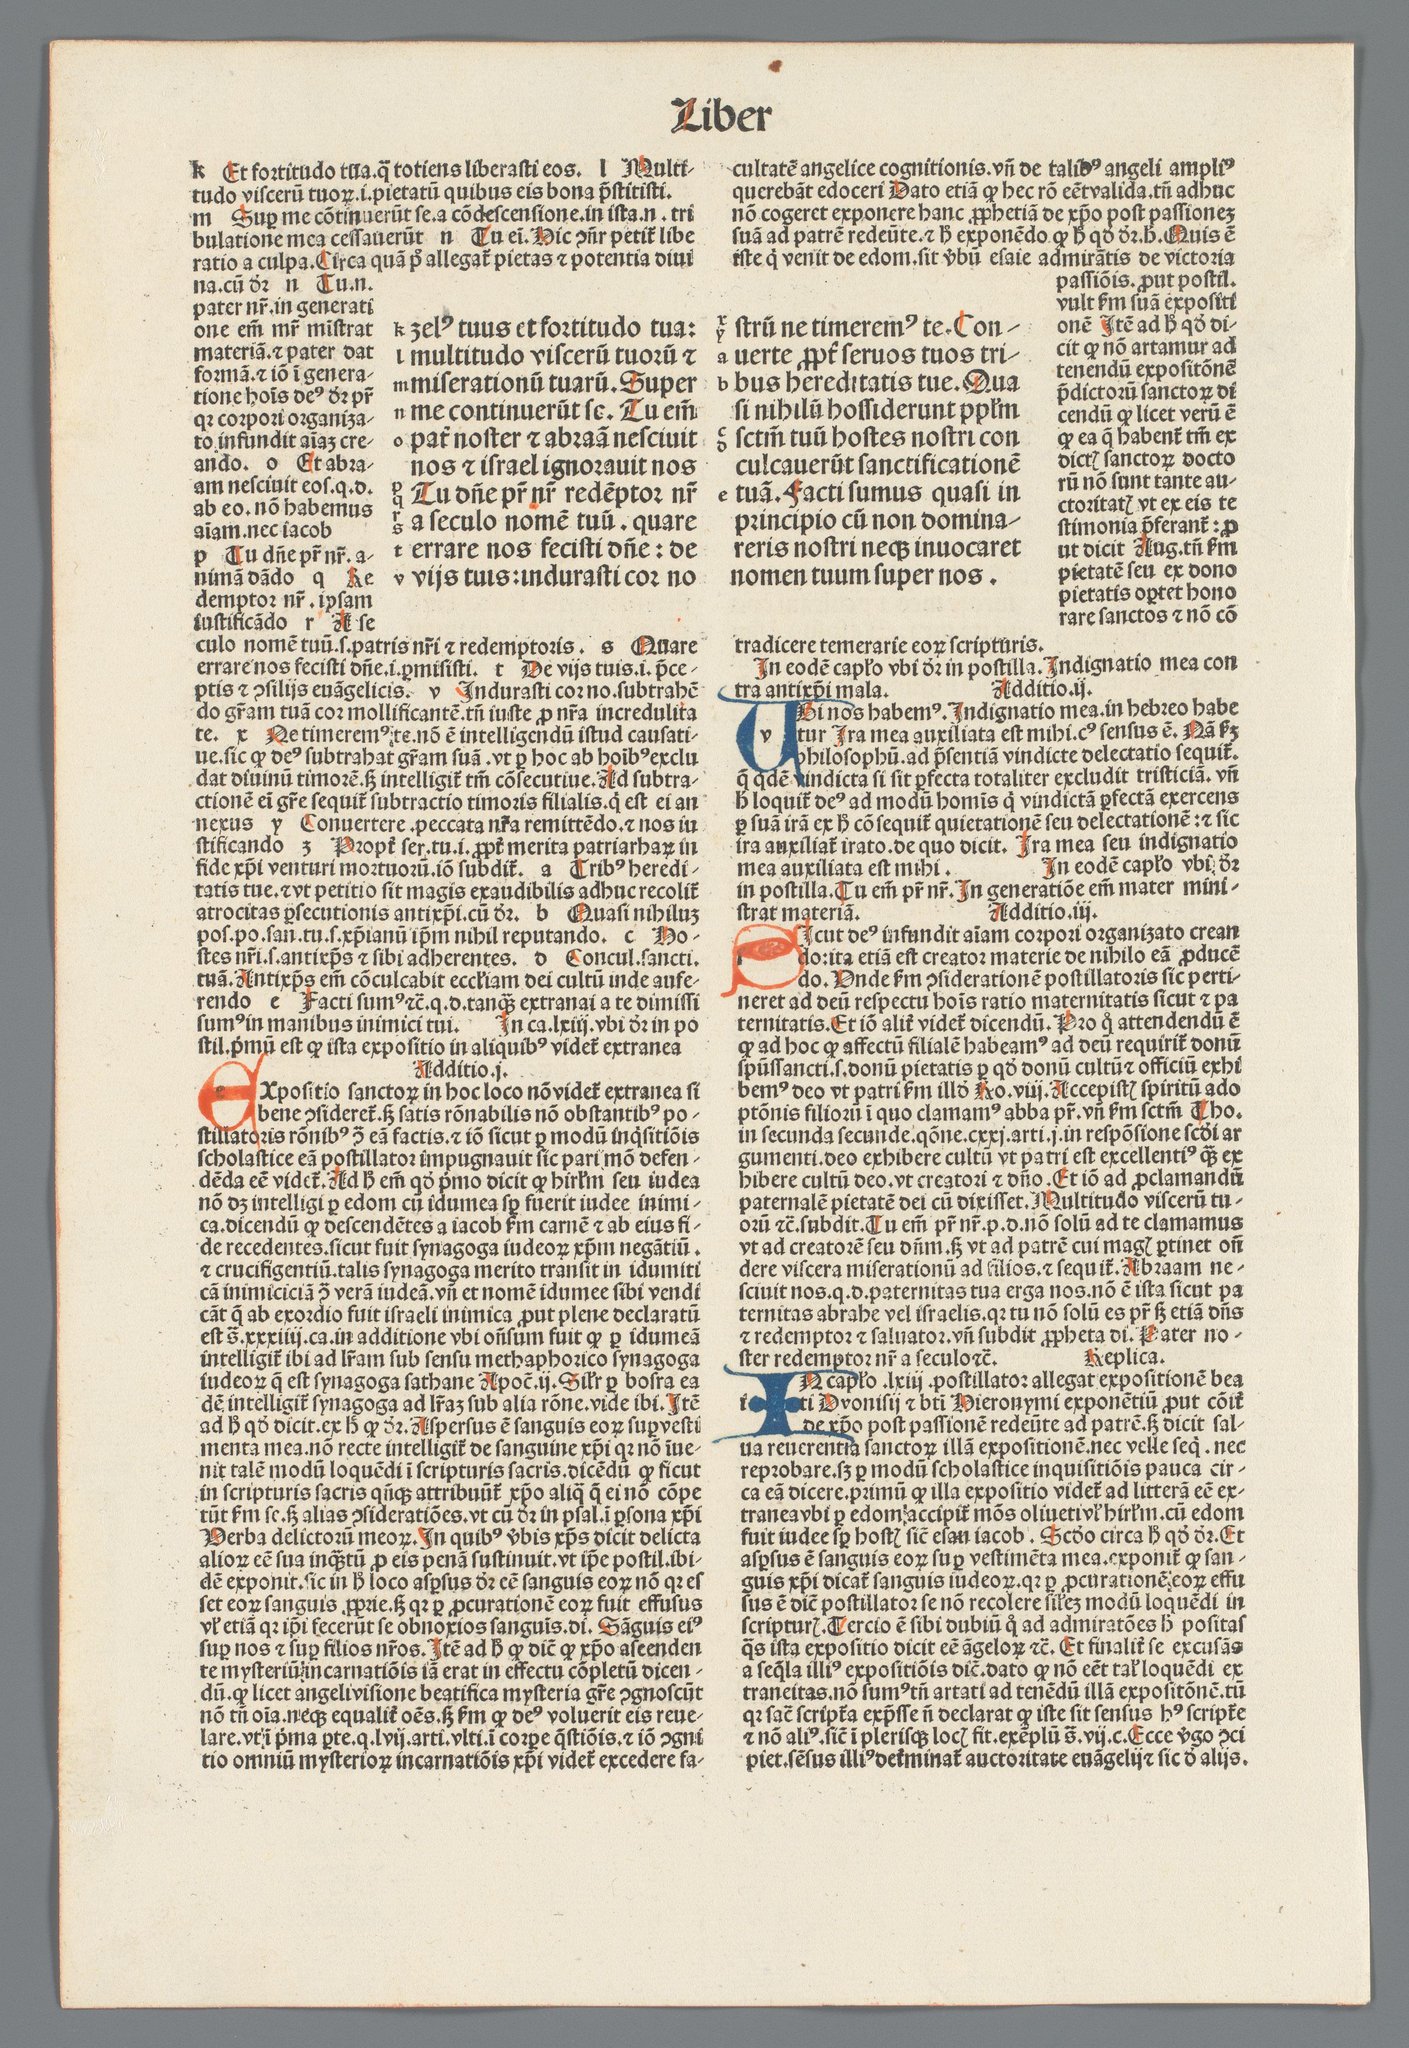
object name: text sheet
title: Bladzijde uit Biblia Latina cum Postillis Nicolai de Lyra, 1493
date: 1493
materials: paper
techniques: hand coloring, letterpress printing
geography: nuremberg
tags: the bible as a book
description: Bladzijde uit: Lyra, Nicolaas van. Biblia Latina cum Postillis Nicolai de Lyra. Neurenberg: Anton Koberger, 1493, dl. 3.